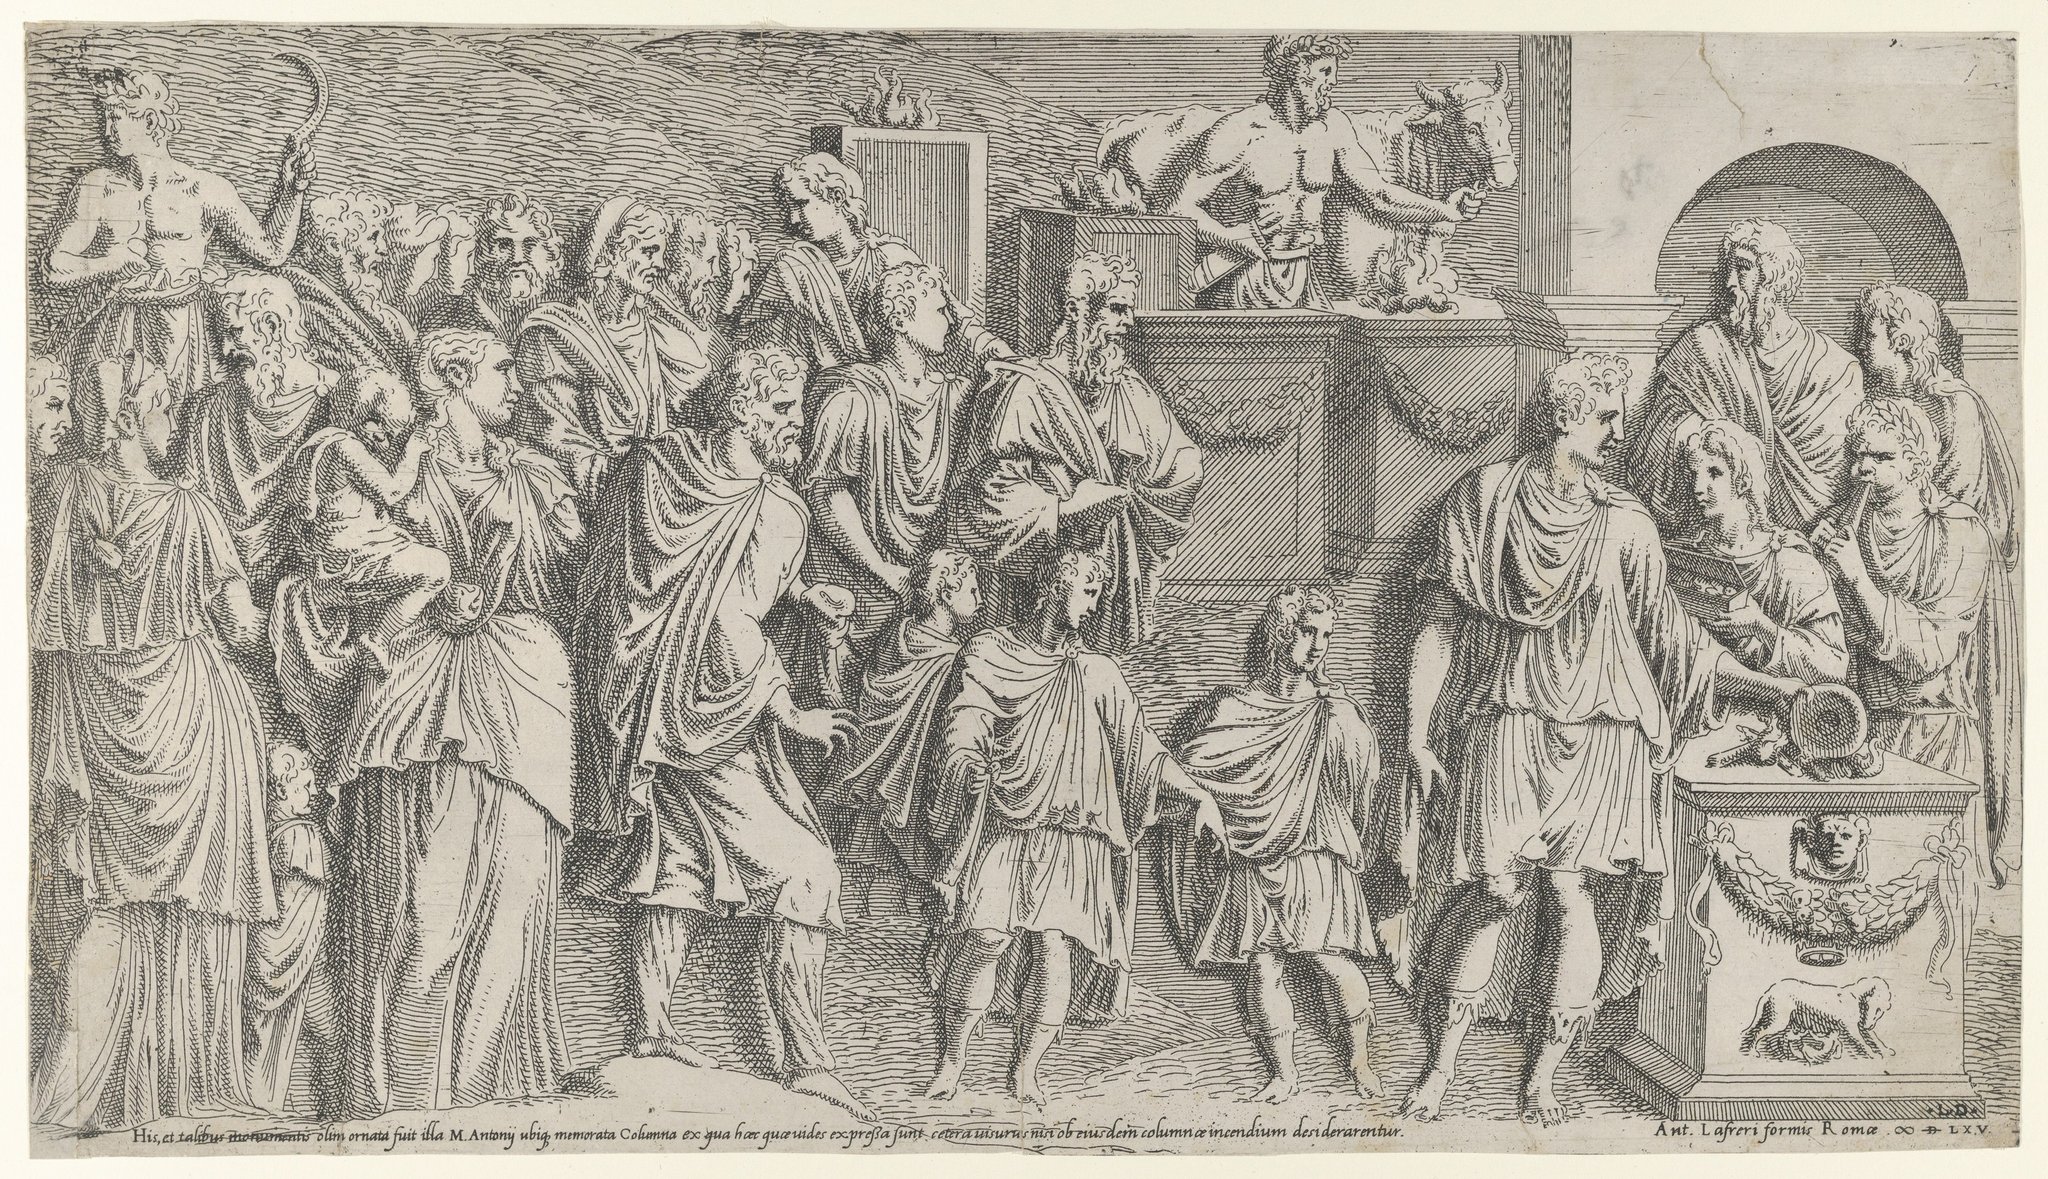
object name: print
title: A sacrifice, copied from Trajan's column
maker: léon davent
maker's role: artist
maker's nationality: french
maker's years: 1540-1556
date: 1540-1545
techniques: etching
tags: animals,weapons,mark antony,men,women